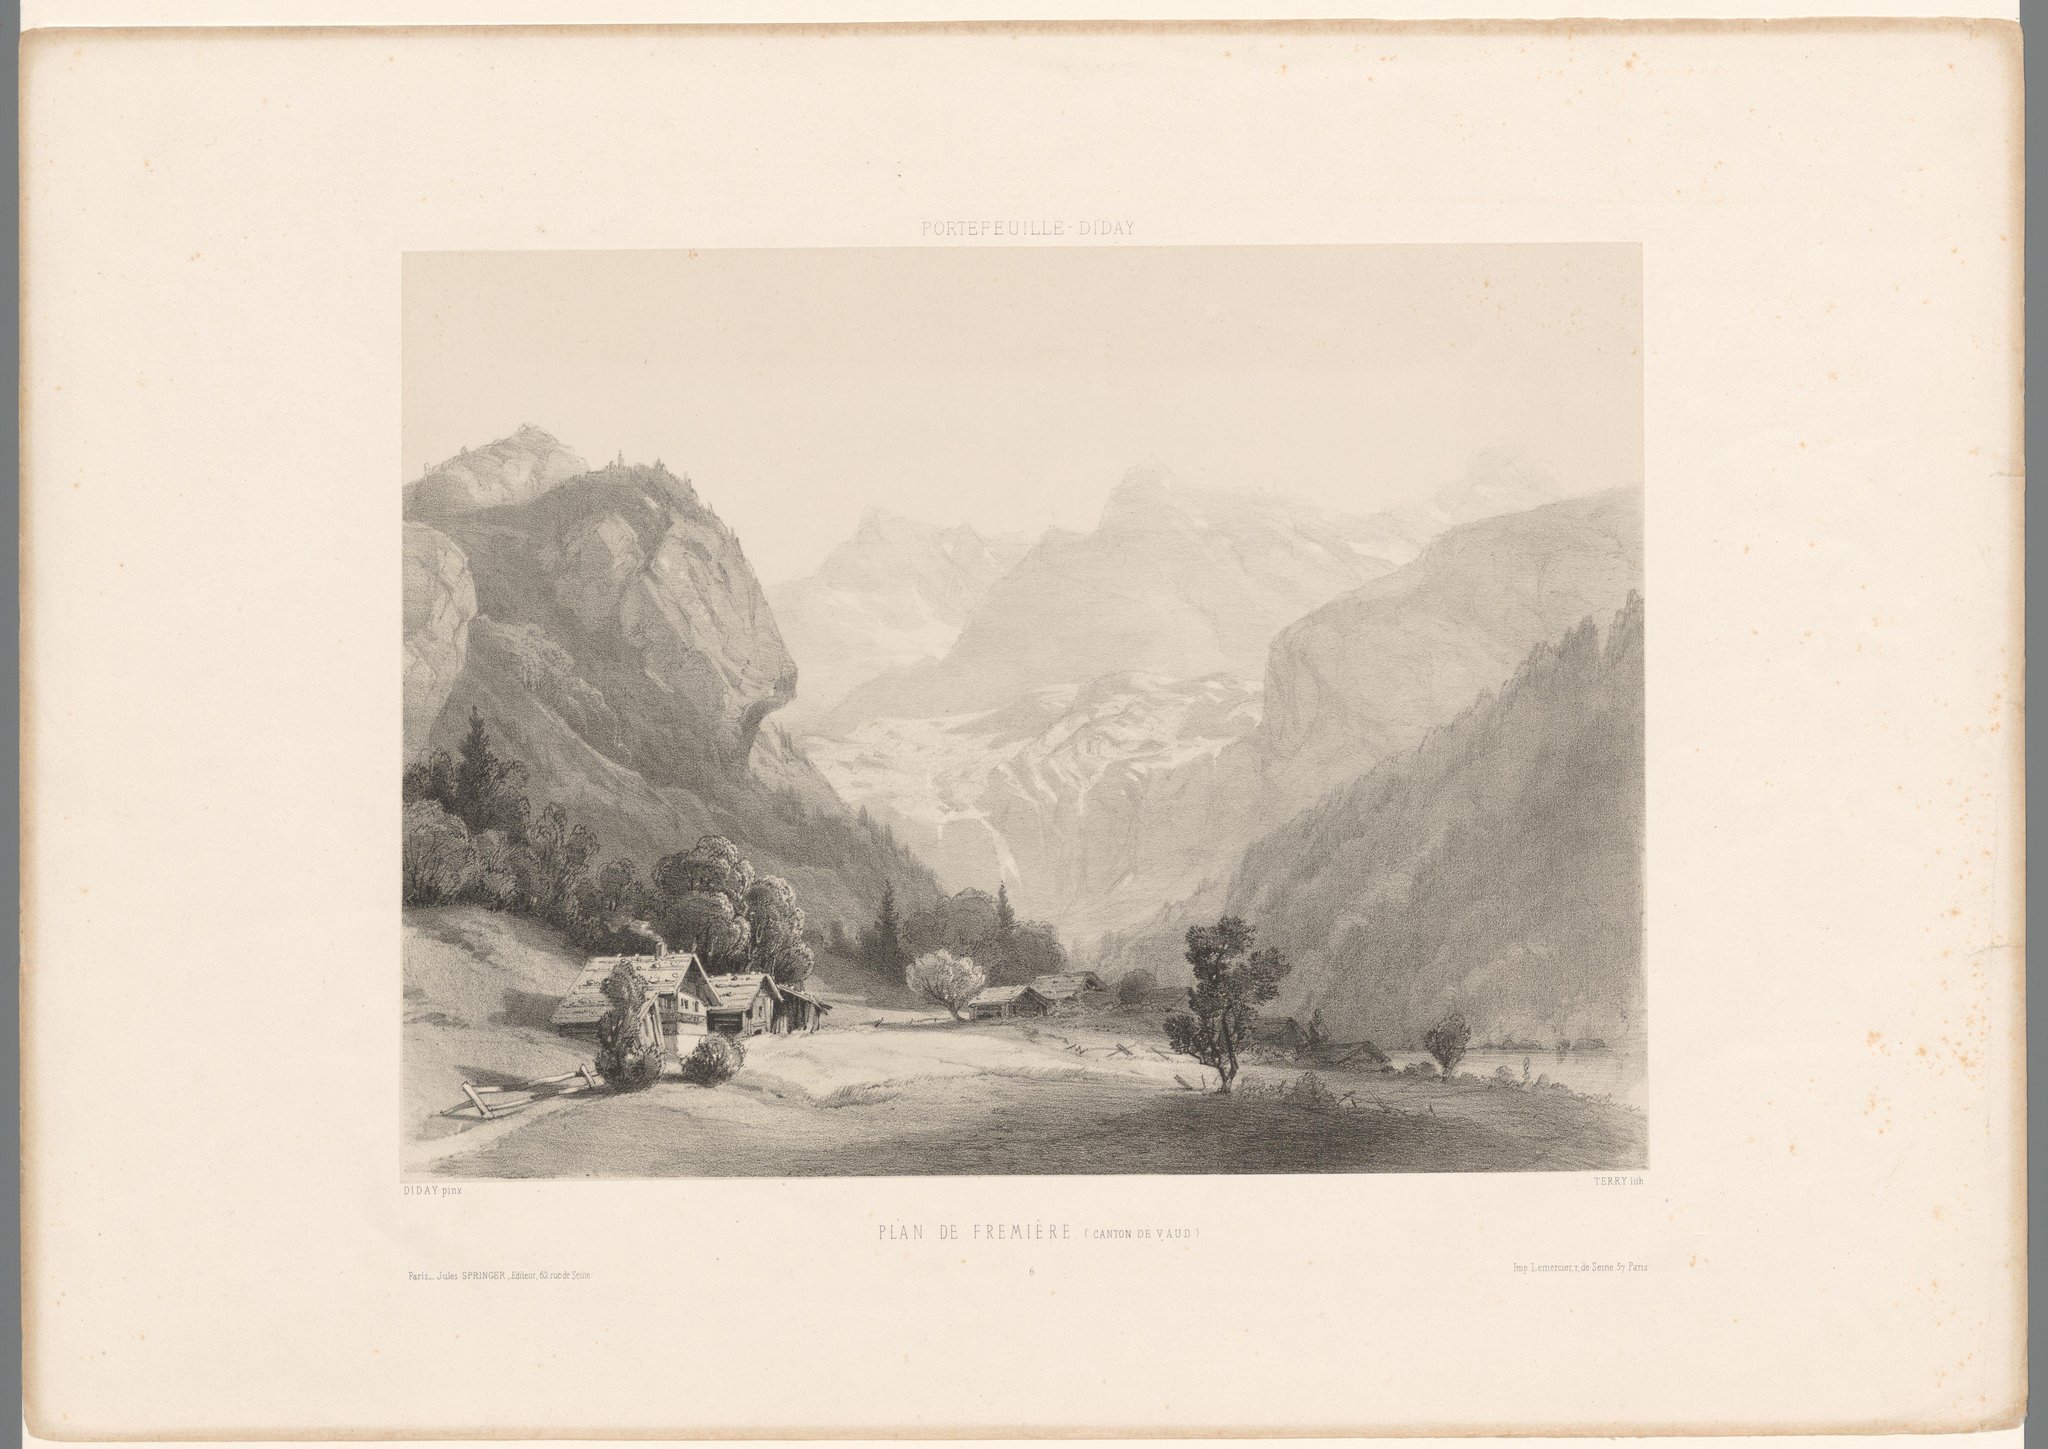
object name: print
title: Berglandschap in Vaud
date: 1828-1880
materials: paper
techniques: tone lithography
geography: paris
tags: mountains (+ landscape with figures, staffage)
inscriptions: collector's mark: Lugt 2228